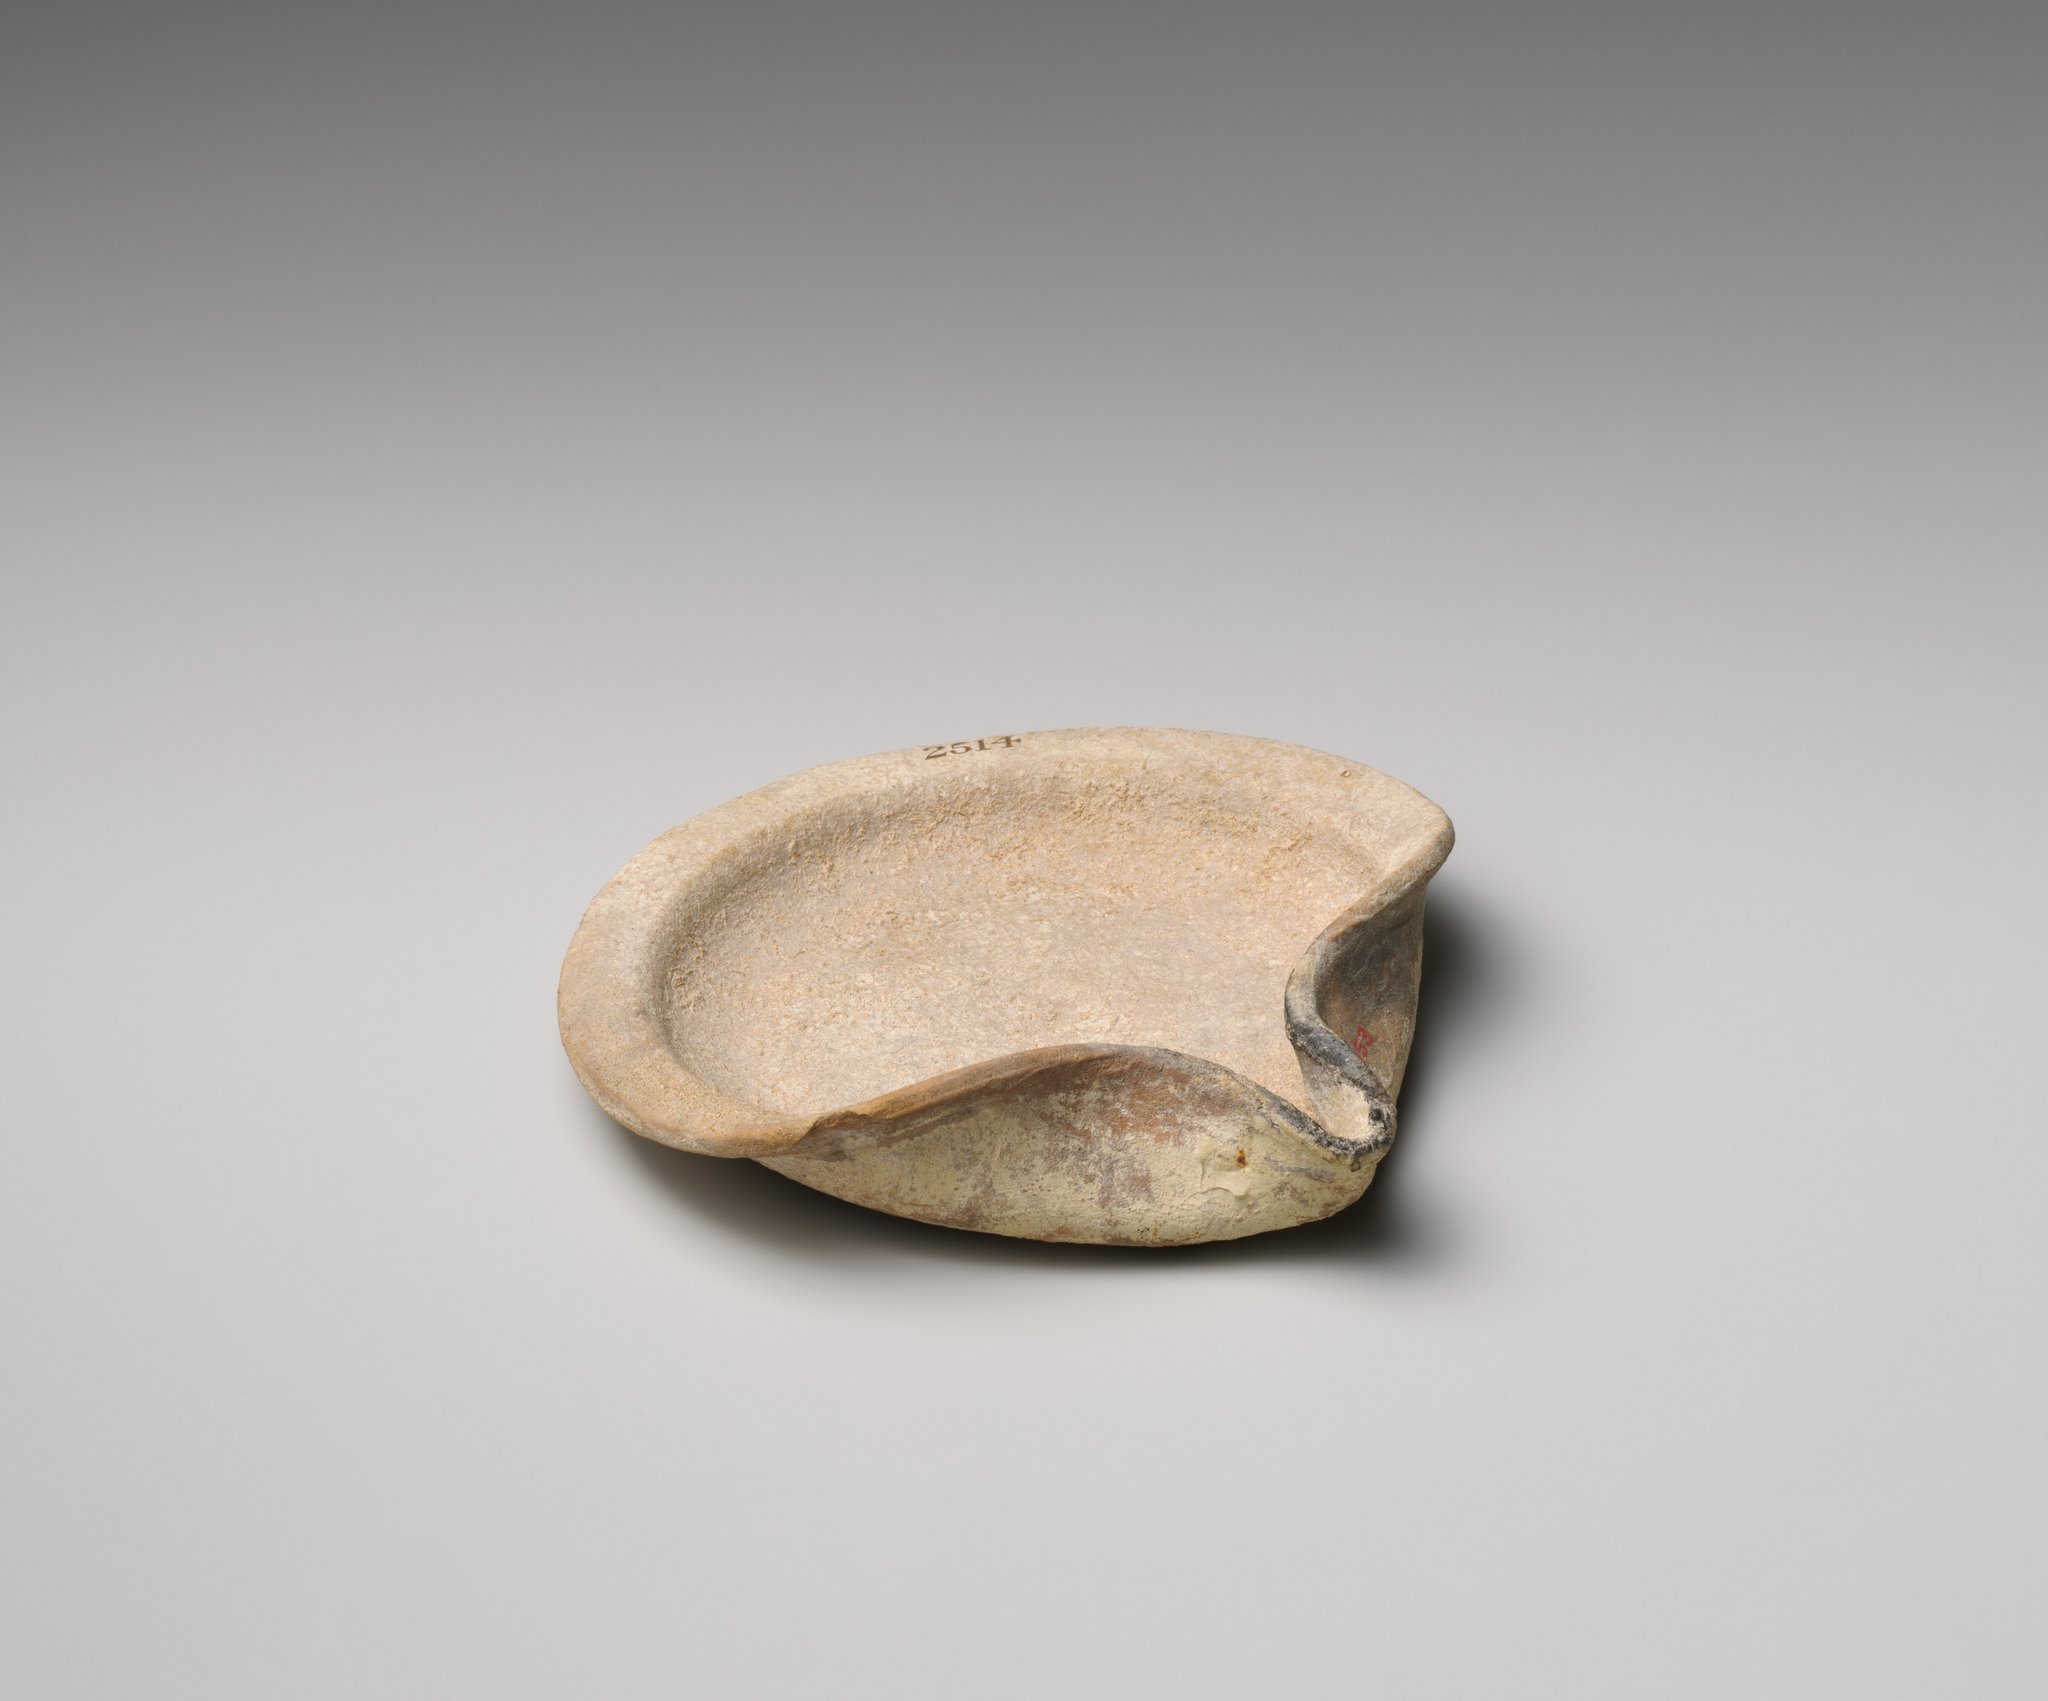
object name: lamp, saucer shaped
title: Terracotta saucer-shaped lamp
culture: cypriot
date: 400-301 BCE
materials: terracotta